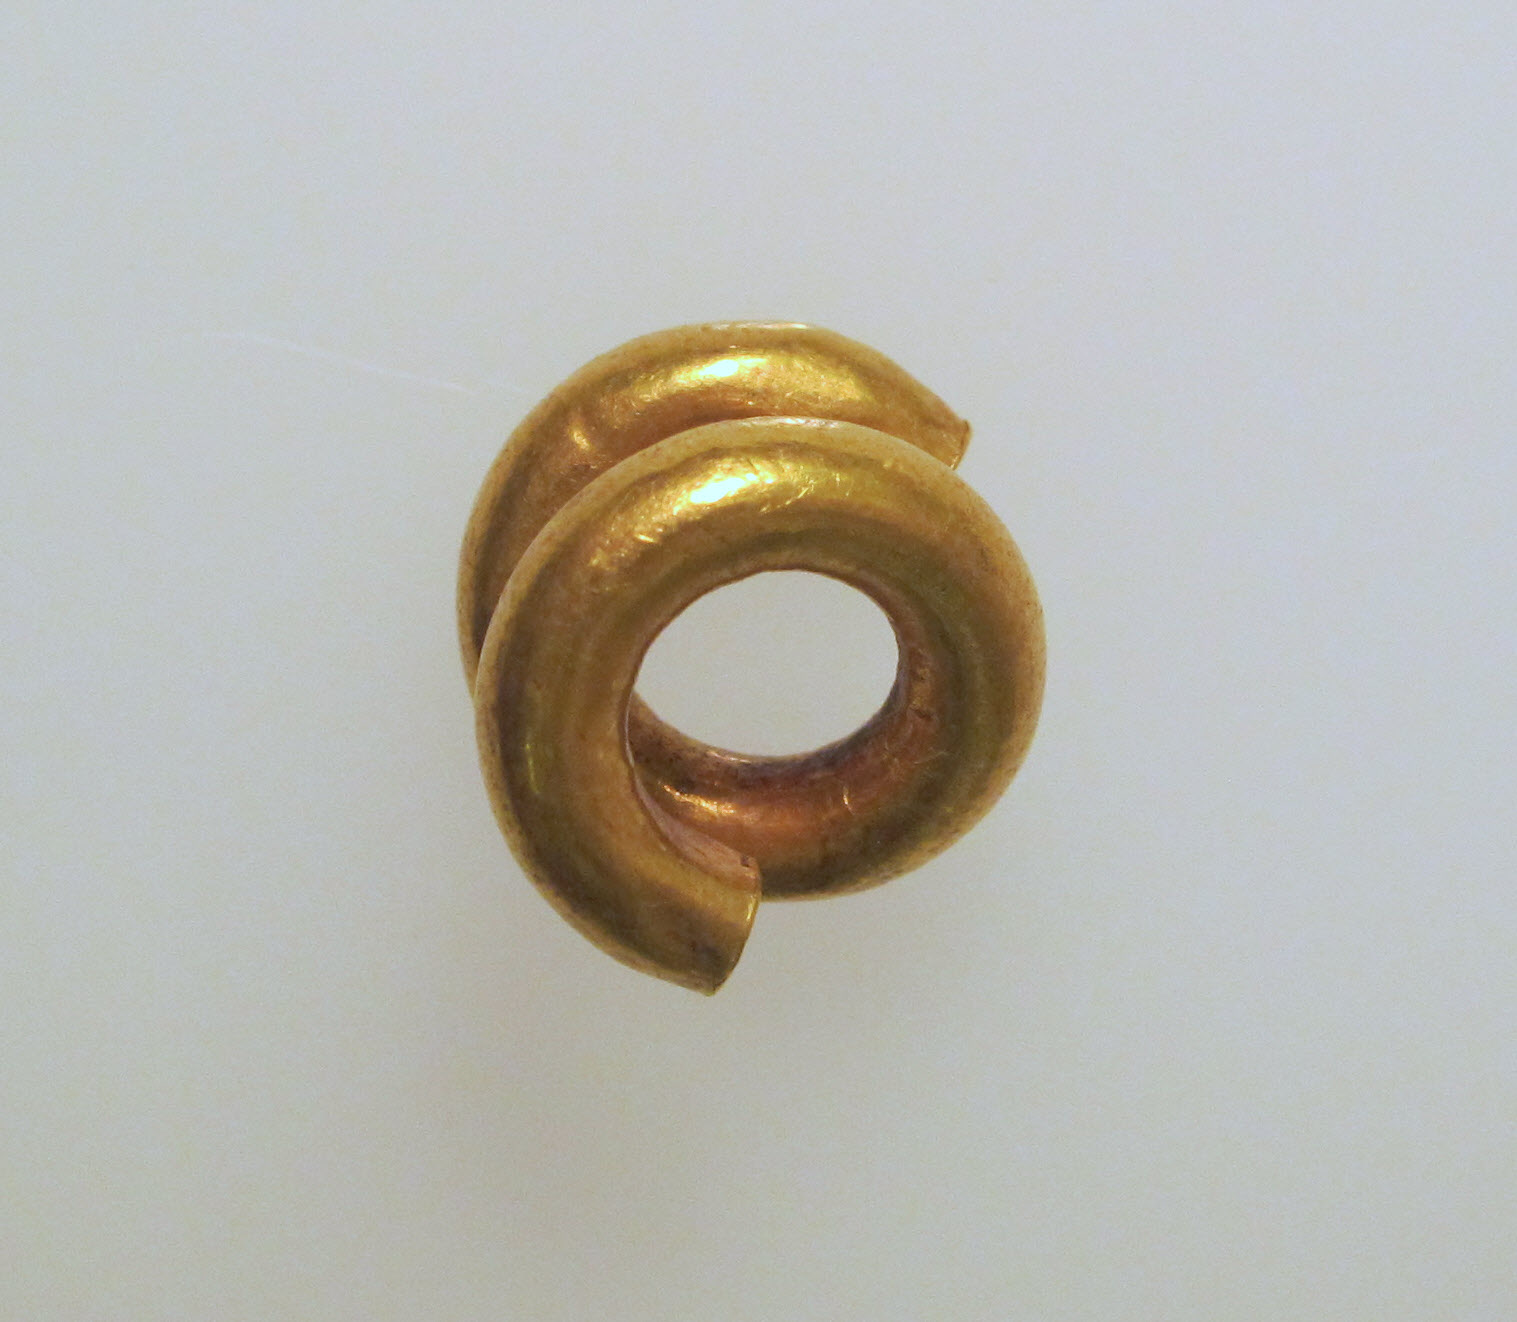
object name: earring or spiral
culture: cypriot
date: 500-401 BCE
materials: bronze, gold